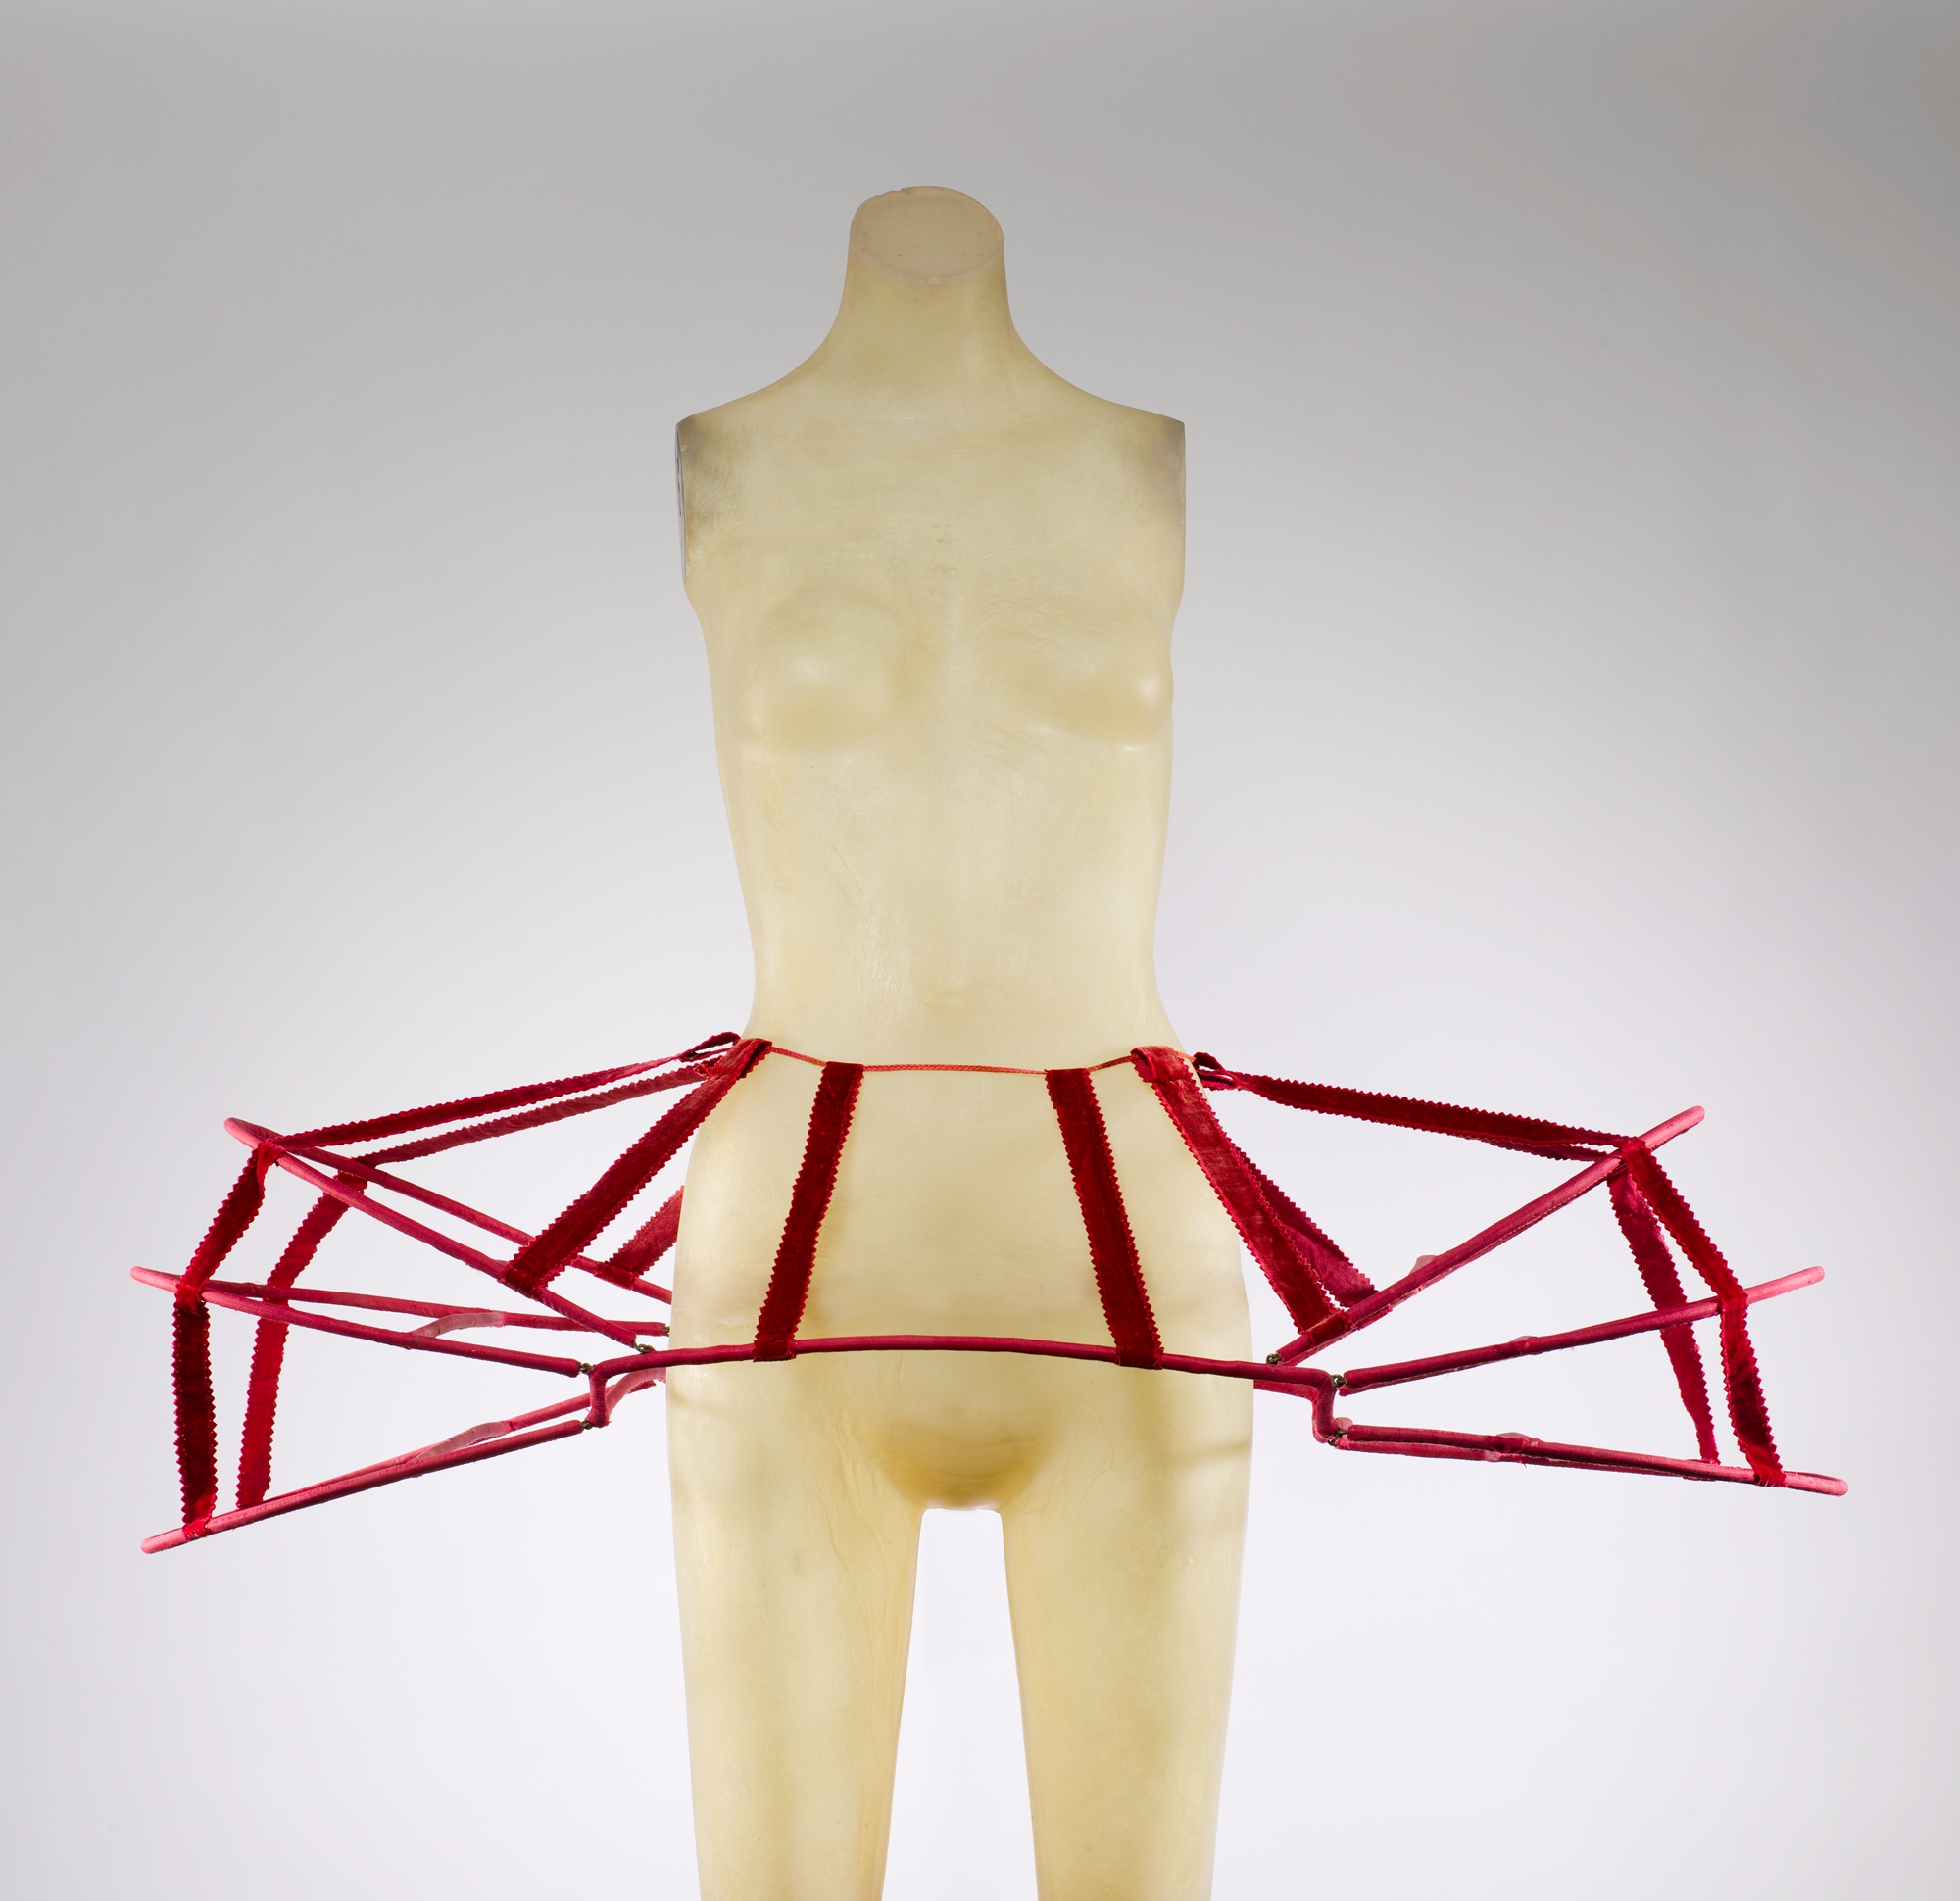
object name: pannier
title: Panniers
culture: french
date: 1760-1770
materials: metal, silk